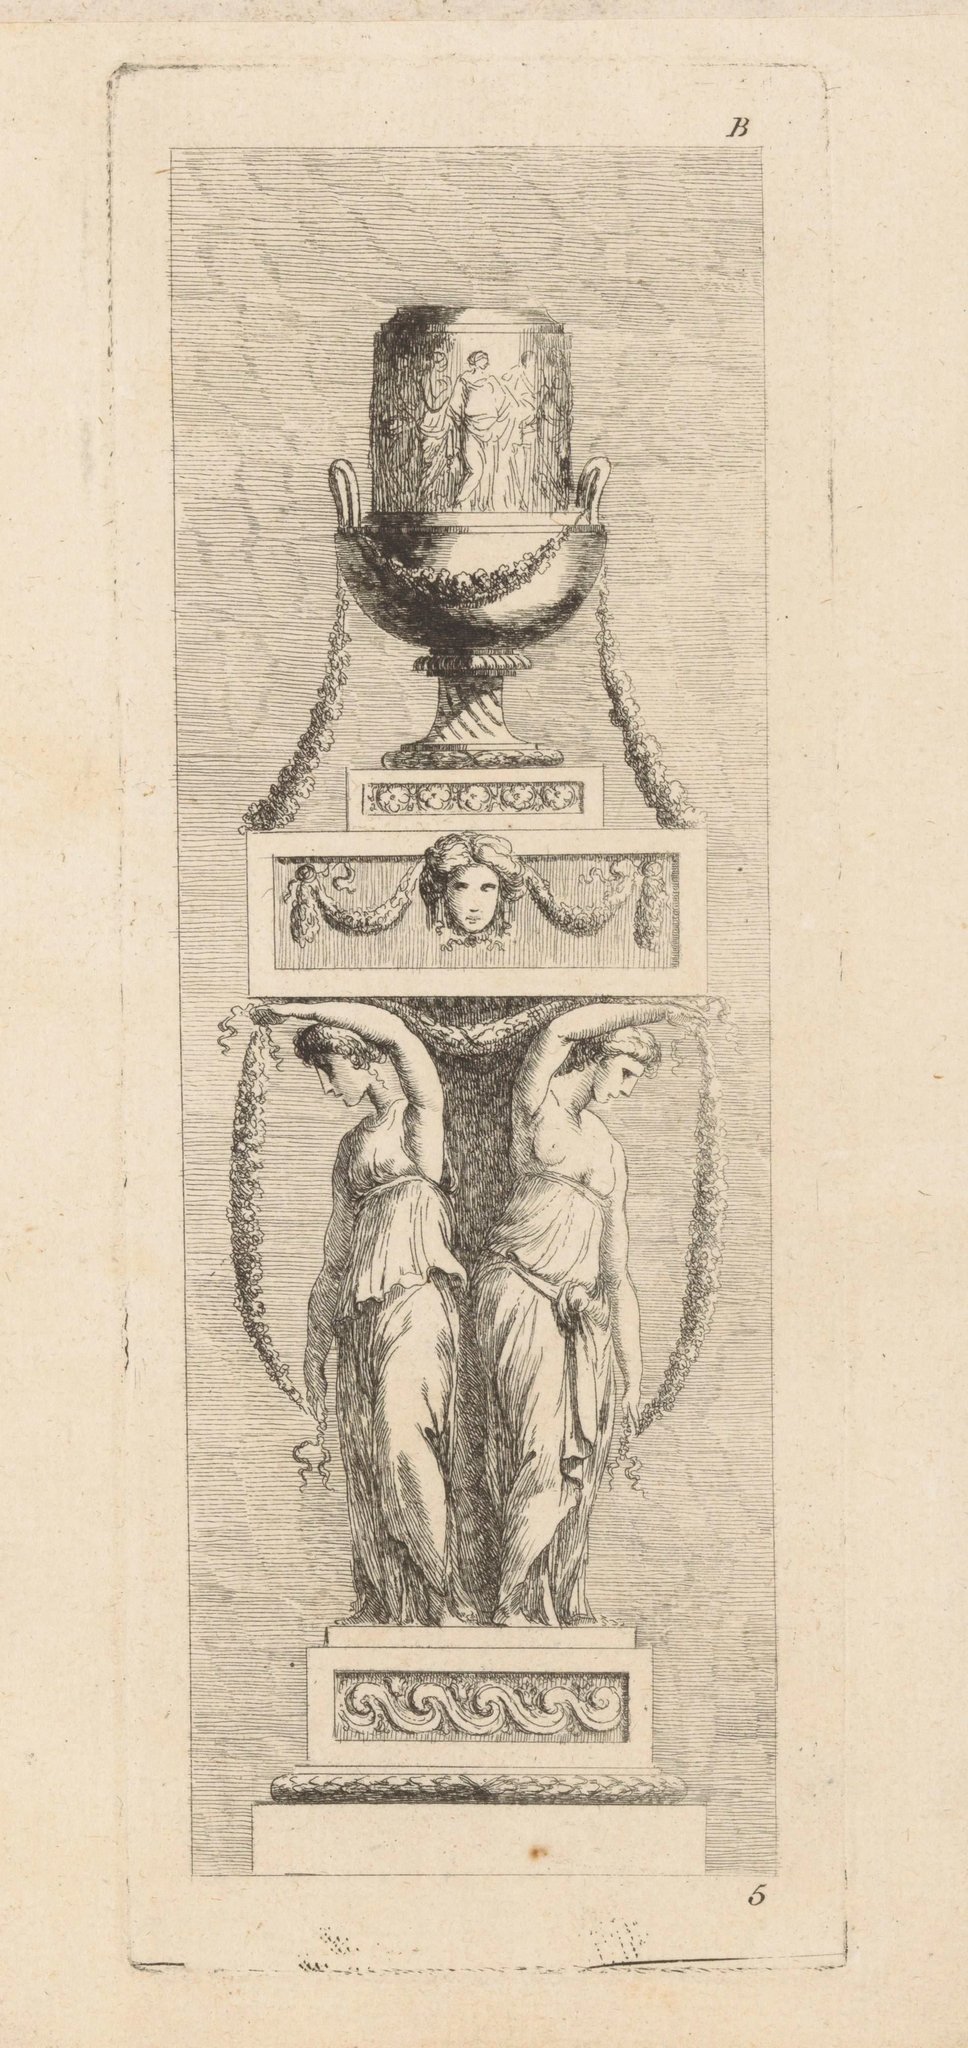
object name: print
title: Vaas en staande vrouwen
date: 1752-1782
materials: paper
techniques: etching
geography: paris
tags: ornament ~ arabesque, vase ~ ornament, standing figure - aa - female human figure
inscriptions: collector's mark: Lugt 2228, collector's mark: Lugt 2760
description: Twee staande vrouwen ondersteunen een voetstuk waarop een vaas staat.